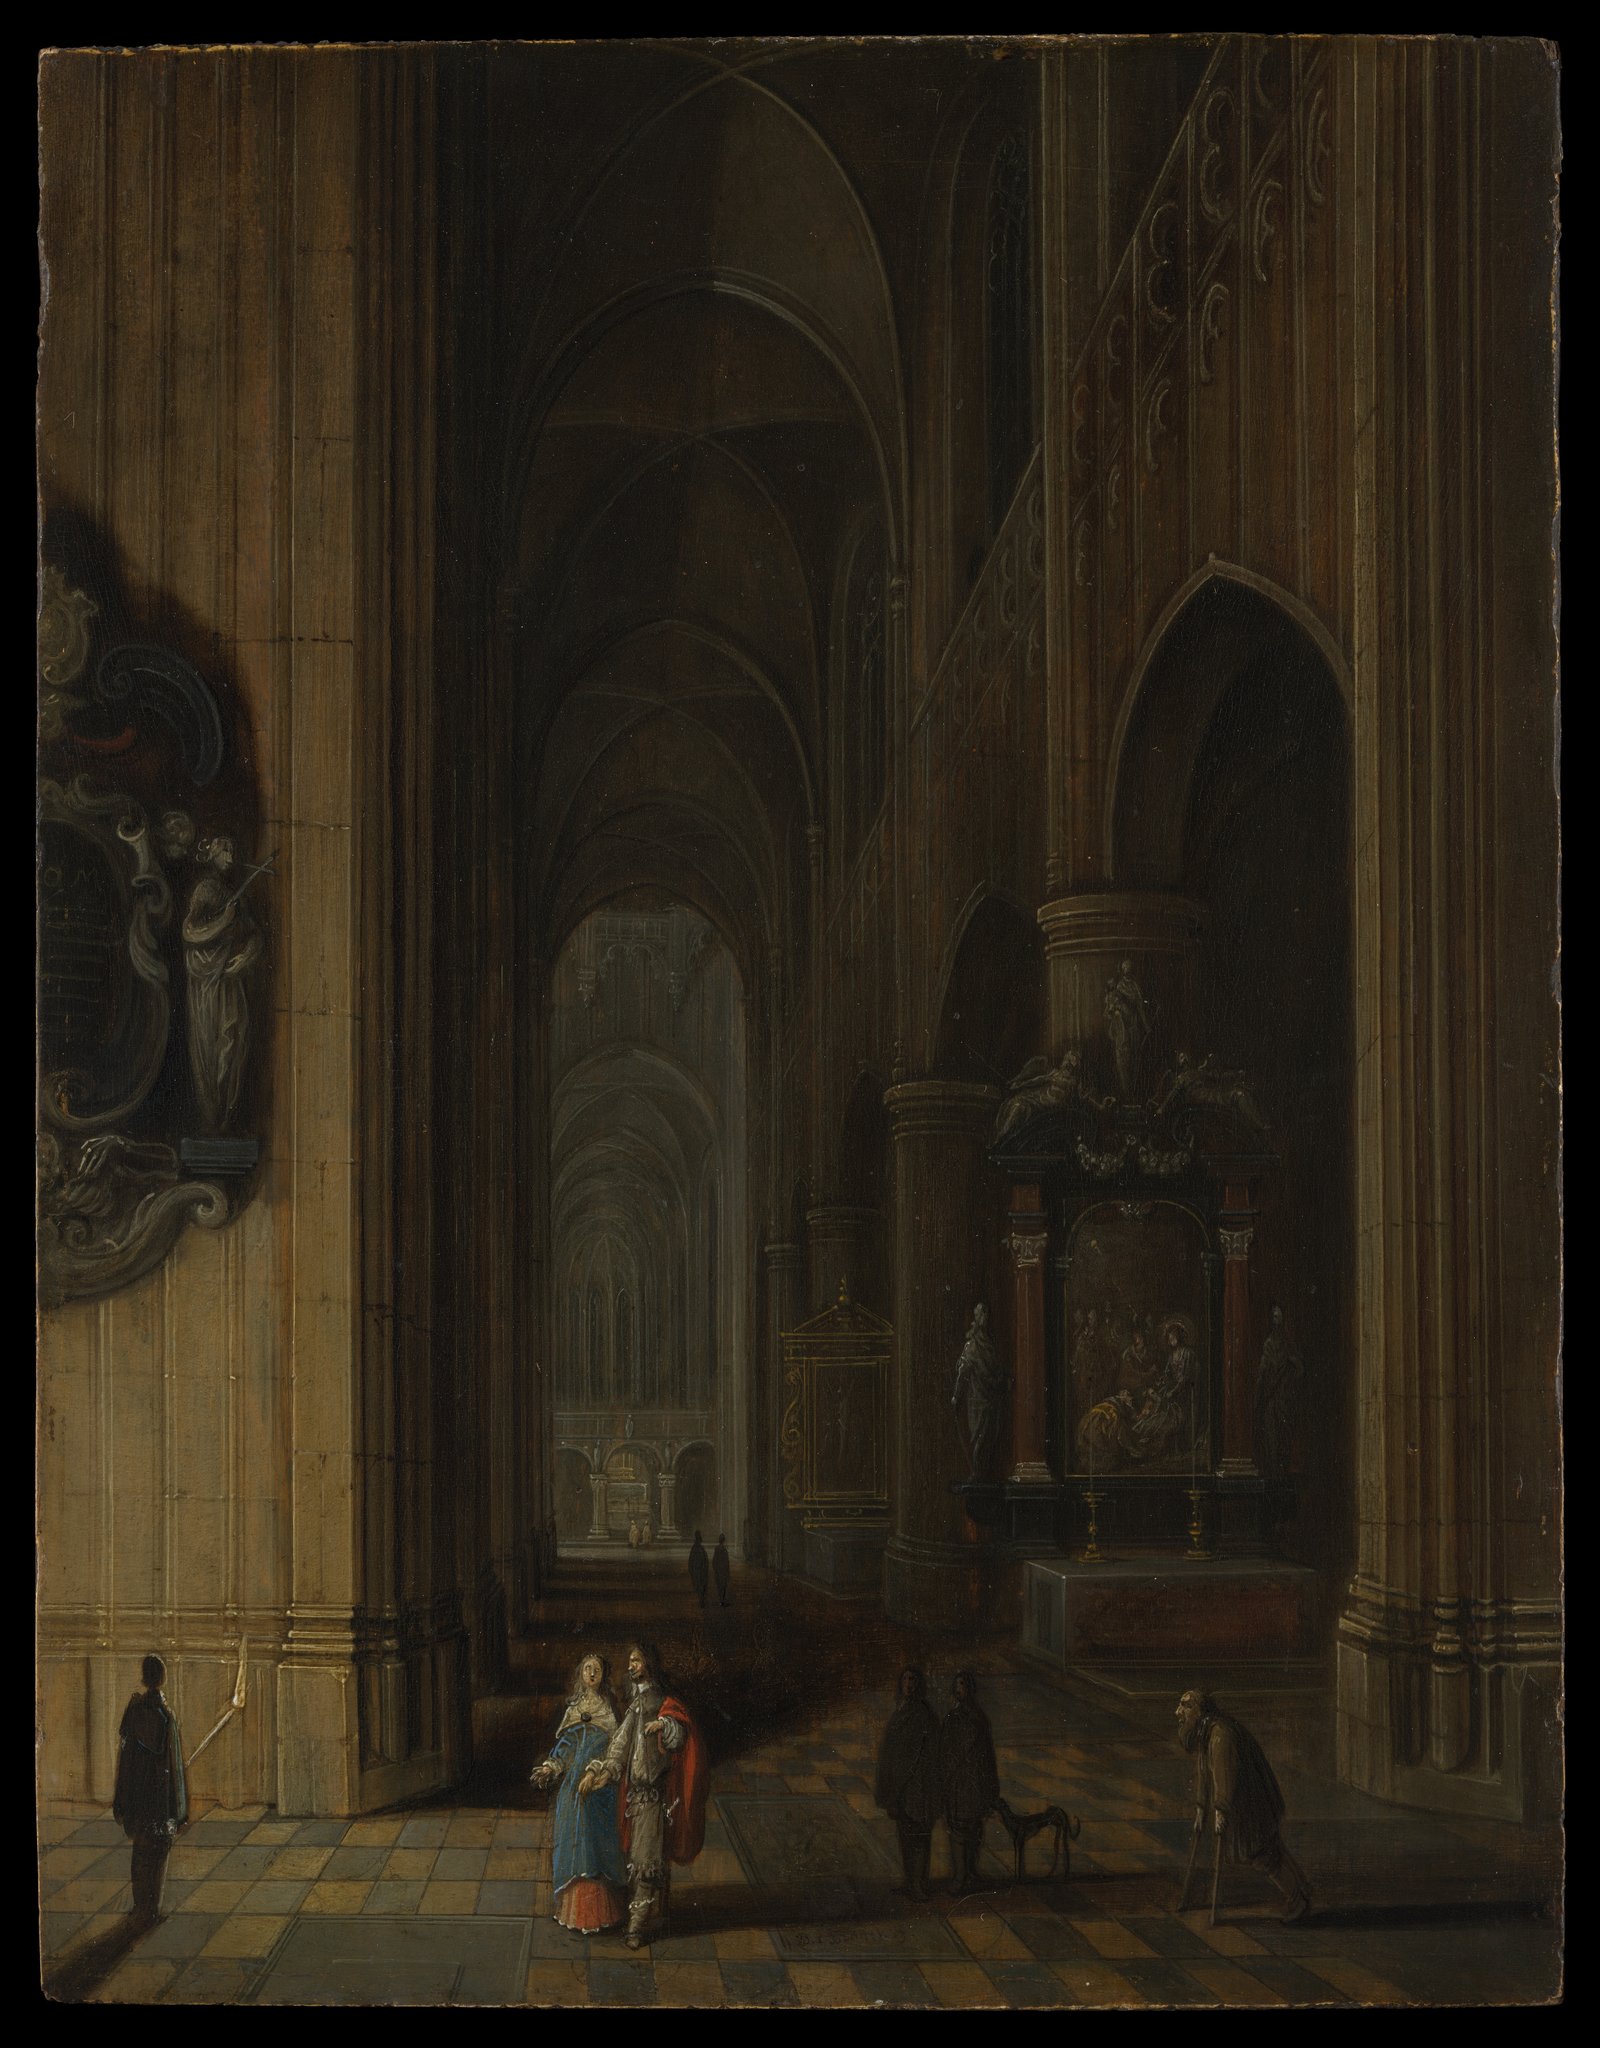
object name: painting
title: Interior of a Gothic Church at Night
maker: pieter neeffs the younger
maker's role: artist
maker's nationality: flemish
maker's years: 1620-1675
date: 1660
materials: oil, wood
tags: arches,interiors,churches